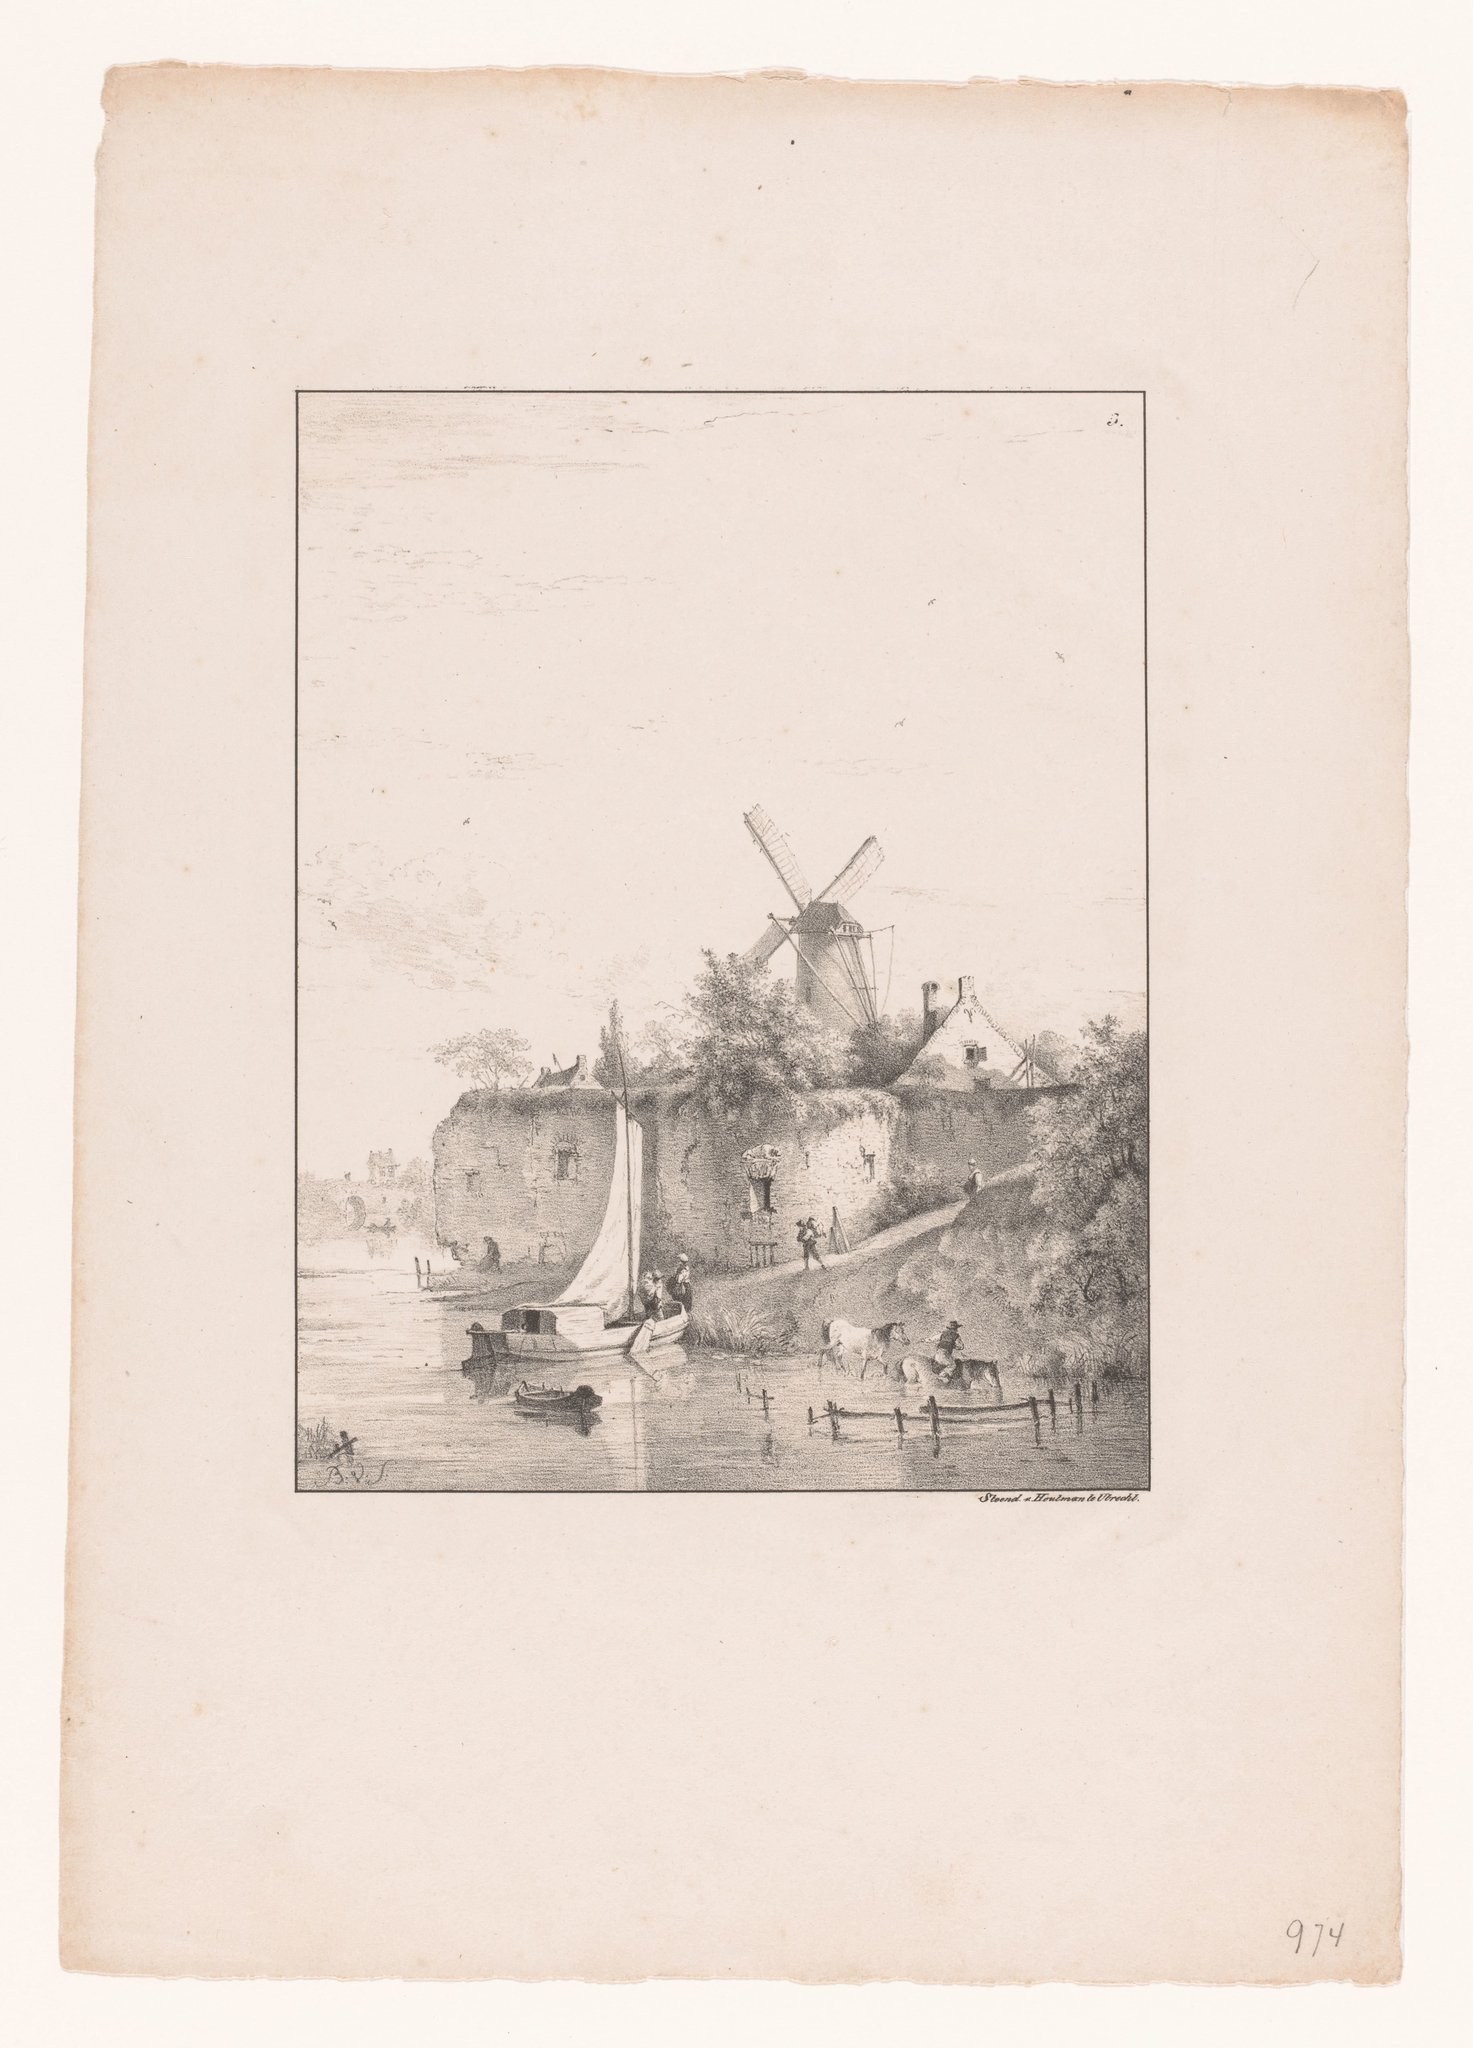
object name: print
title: Gezicht op bolwerk Morgenster te Utrecht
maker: bruno van straaten (i)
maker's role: draughtsman, print maker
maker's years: 1786-1870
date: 1829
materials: paper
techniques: lithograph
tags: sailing-ship, sailing-boat, river, windmill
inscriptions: collector's mark: Lugt 2228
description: Gezicht op het bastion Morgenster te Utrecht met de molen Klaarwater (opvolger), gezien vanaf de Weerdpoort. Aan de singel is een zeilschip aangemeerd. Rechts daarvan een ruiter te paard die een ander paard door het water leidt.